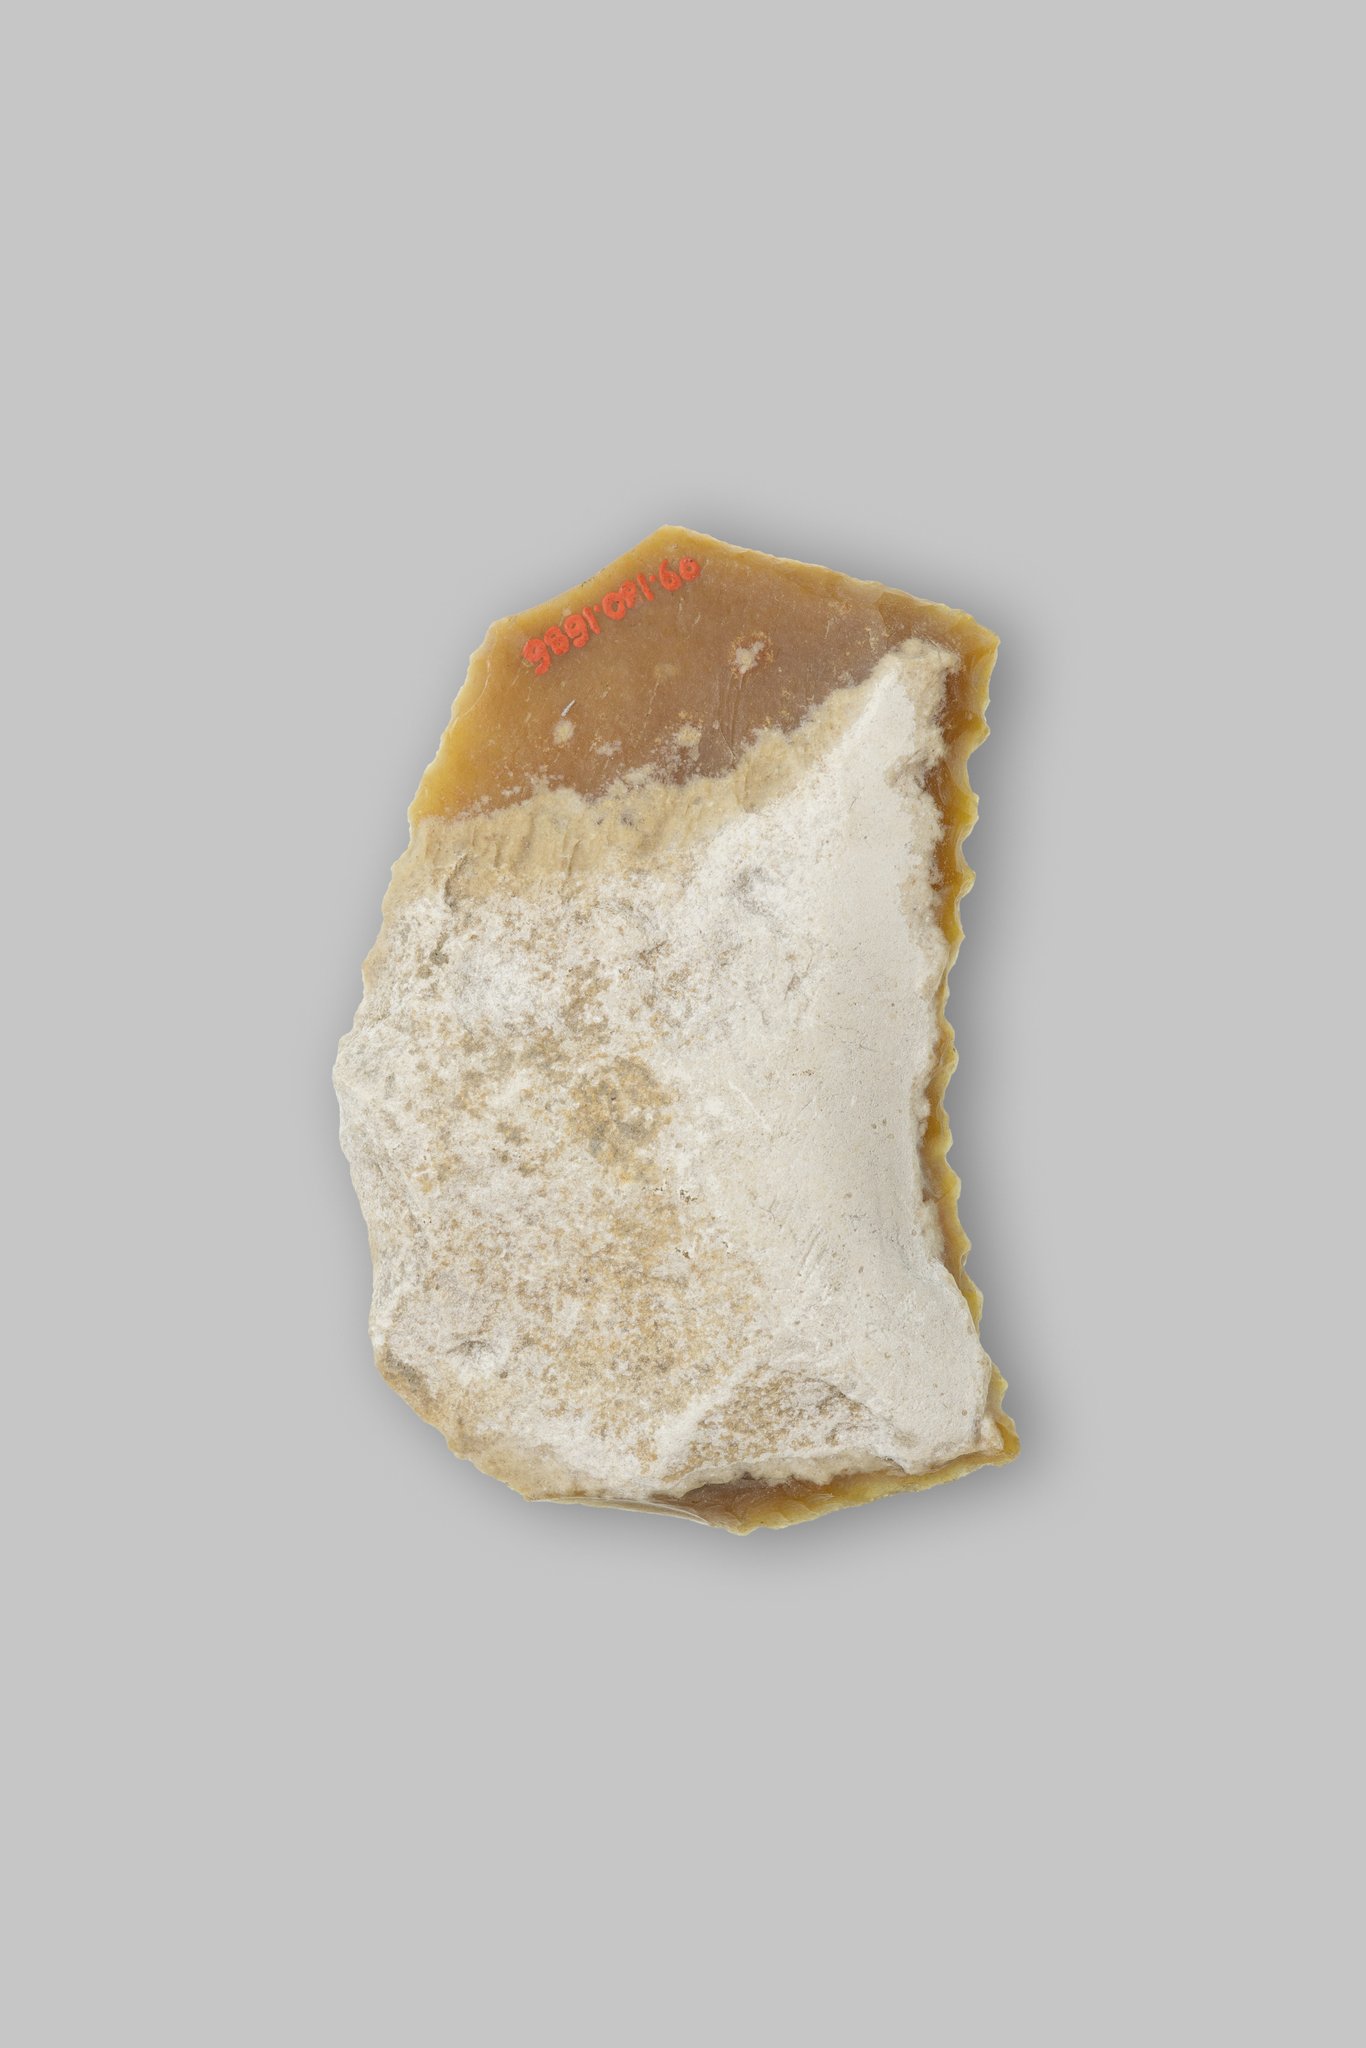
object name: sickle, denticulate, truncated, backed, geometric, tool, element, adhesive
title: Sickle Insert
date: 1186-1070 BCE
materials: stone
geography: egypt